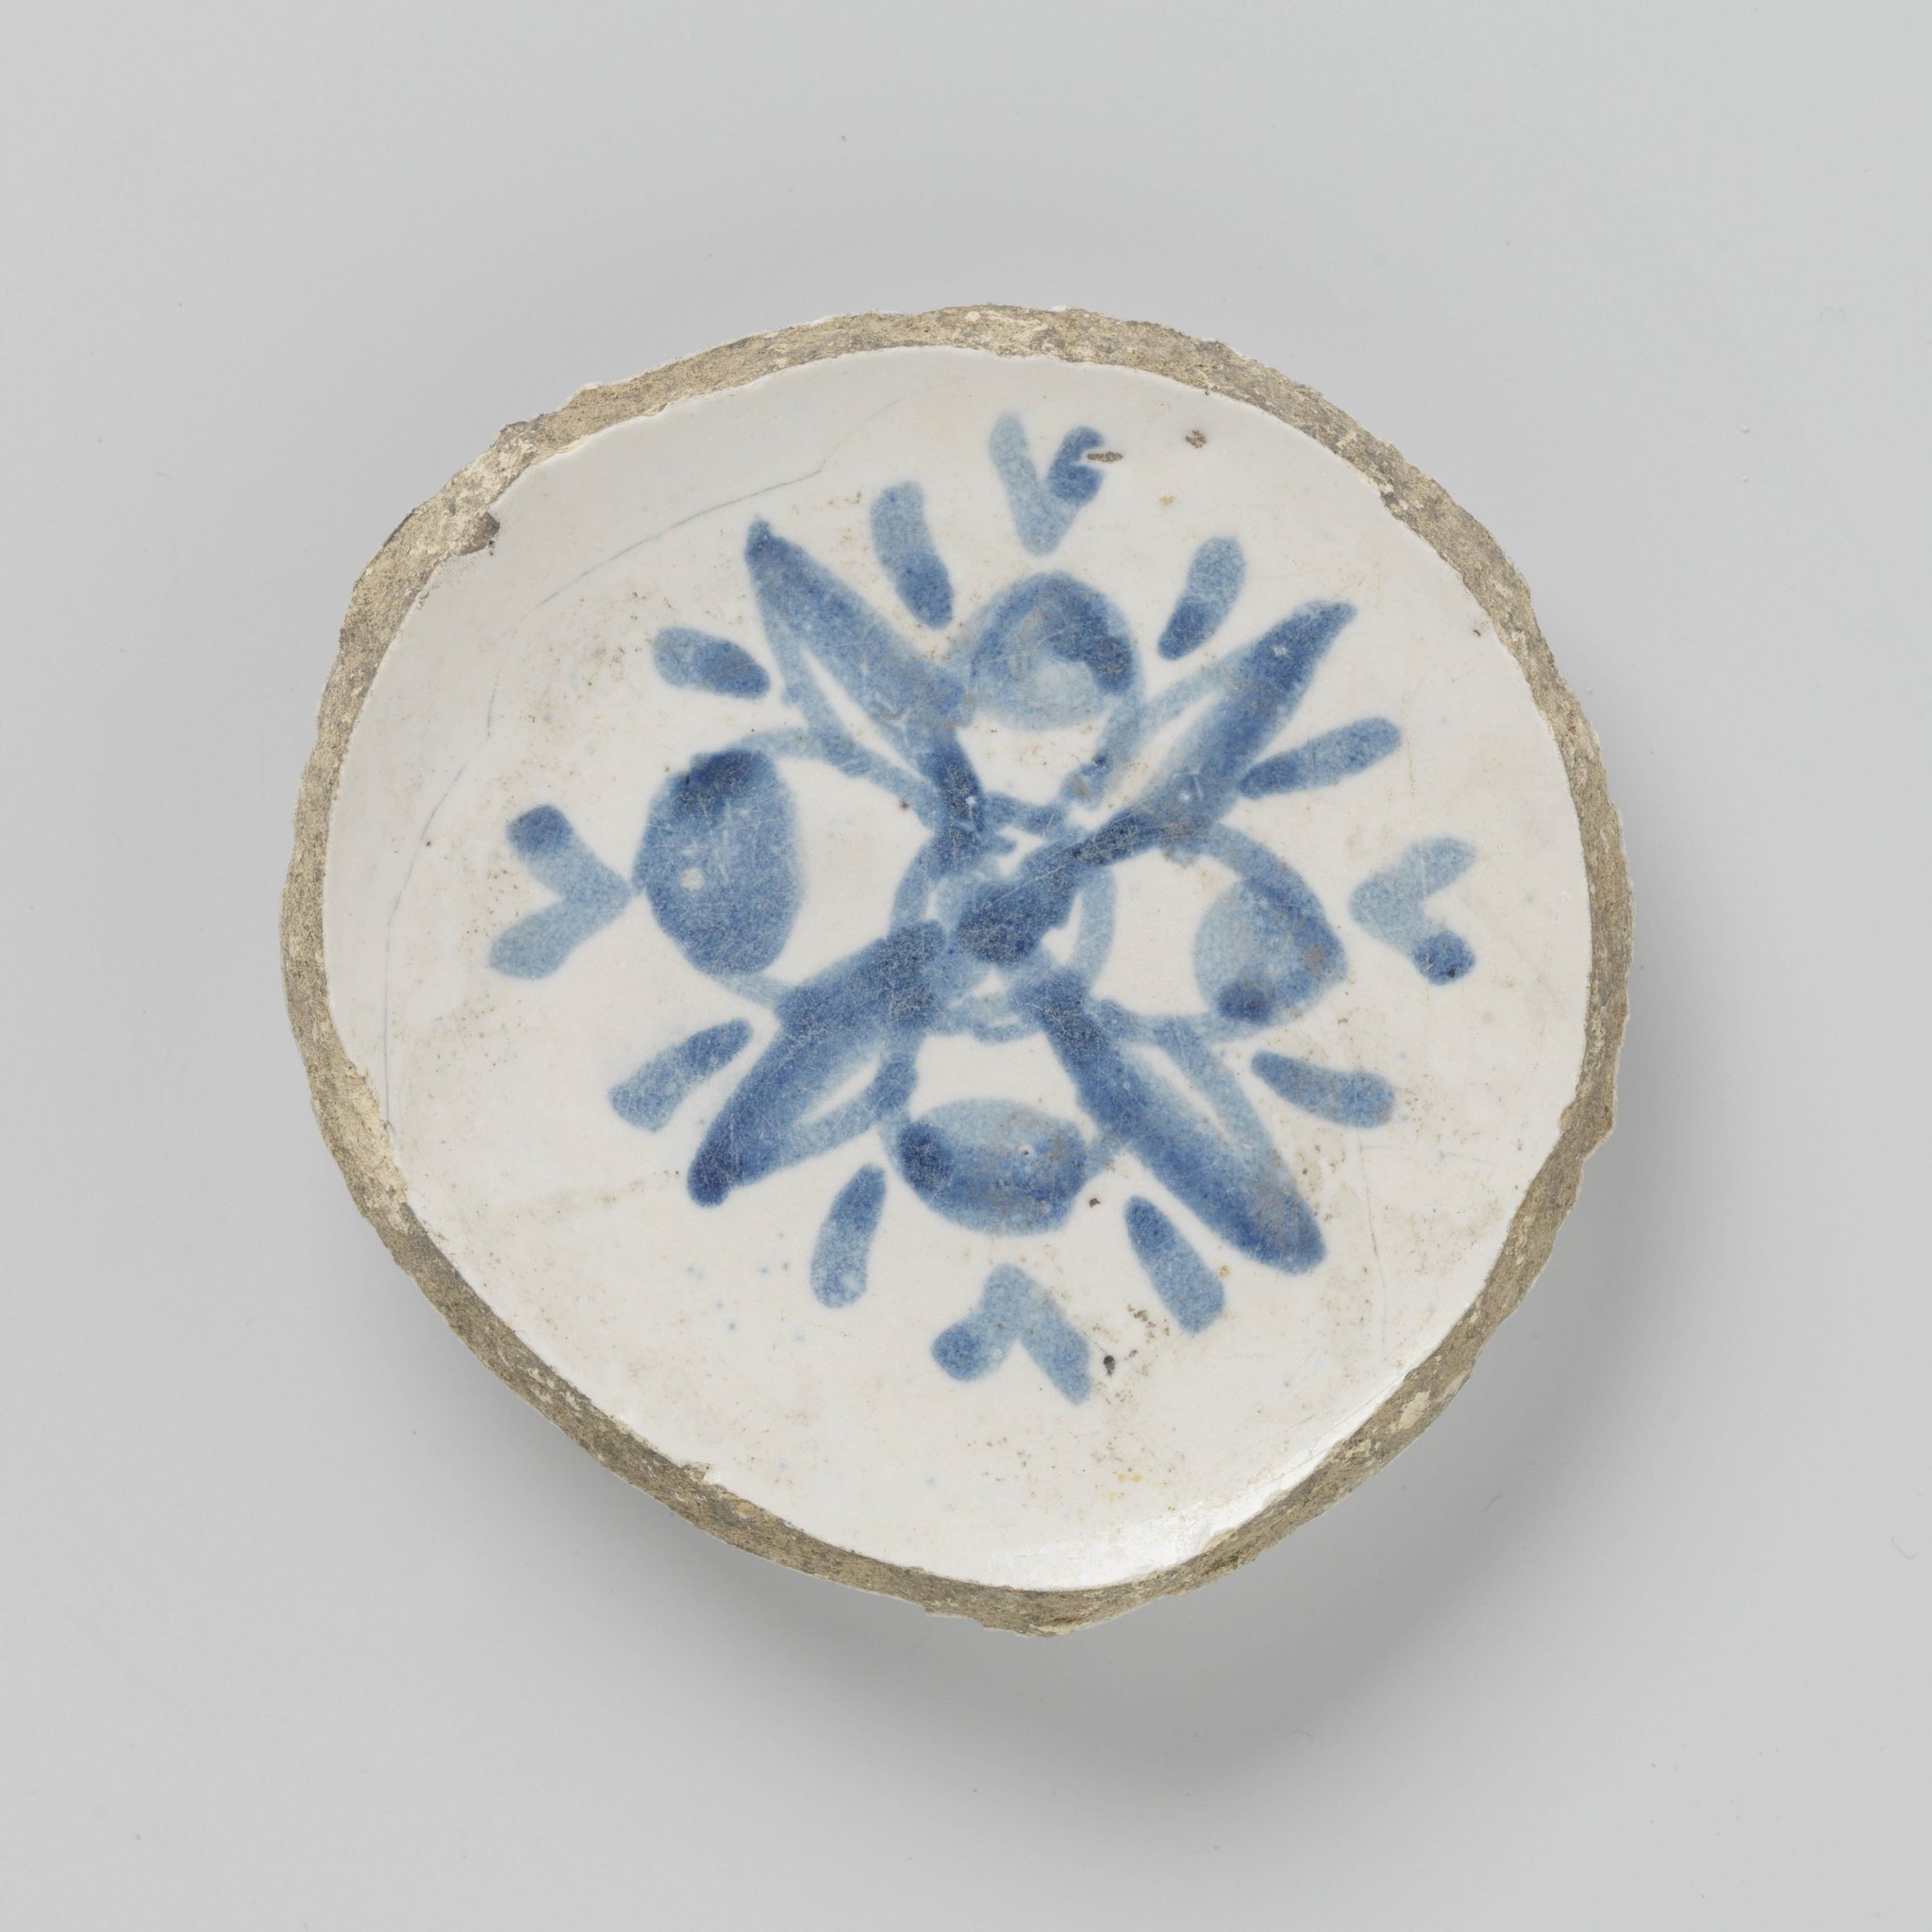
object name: fragment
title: Scherf van aardewerk versierd met geometrische ornamenten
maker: Anonymous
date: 1700-1750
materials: earthenware, glaze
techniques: painted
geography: england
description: Fragment van blauw beschilderde faience. Op het fragment is een geometrisch ornament geschilderd. Opgegraven in Londen.